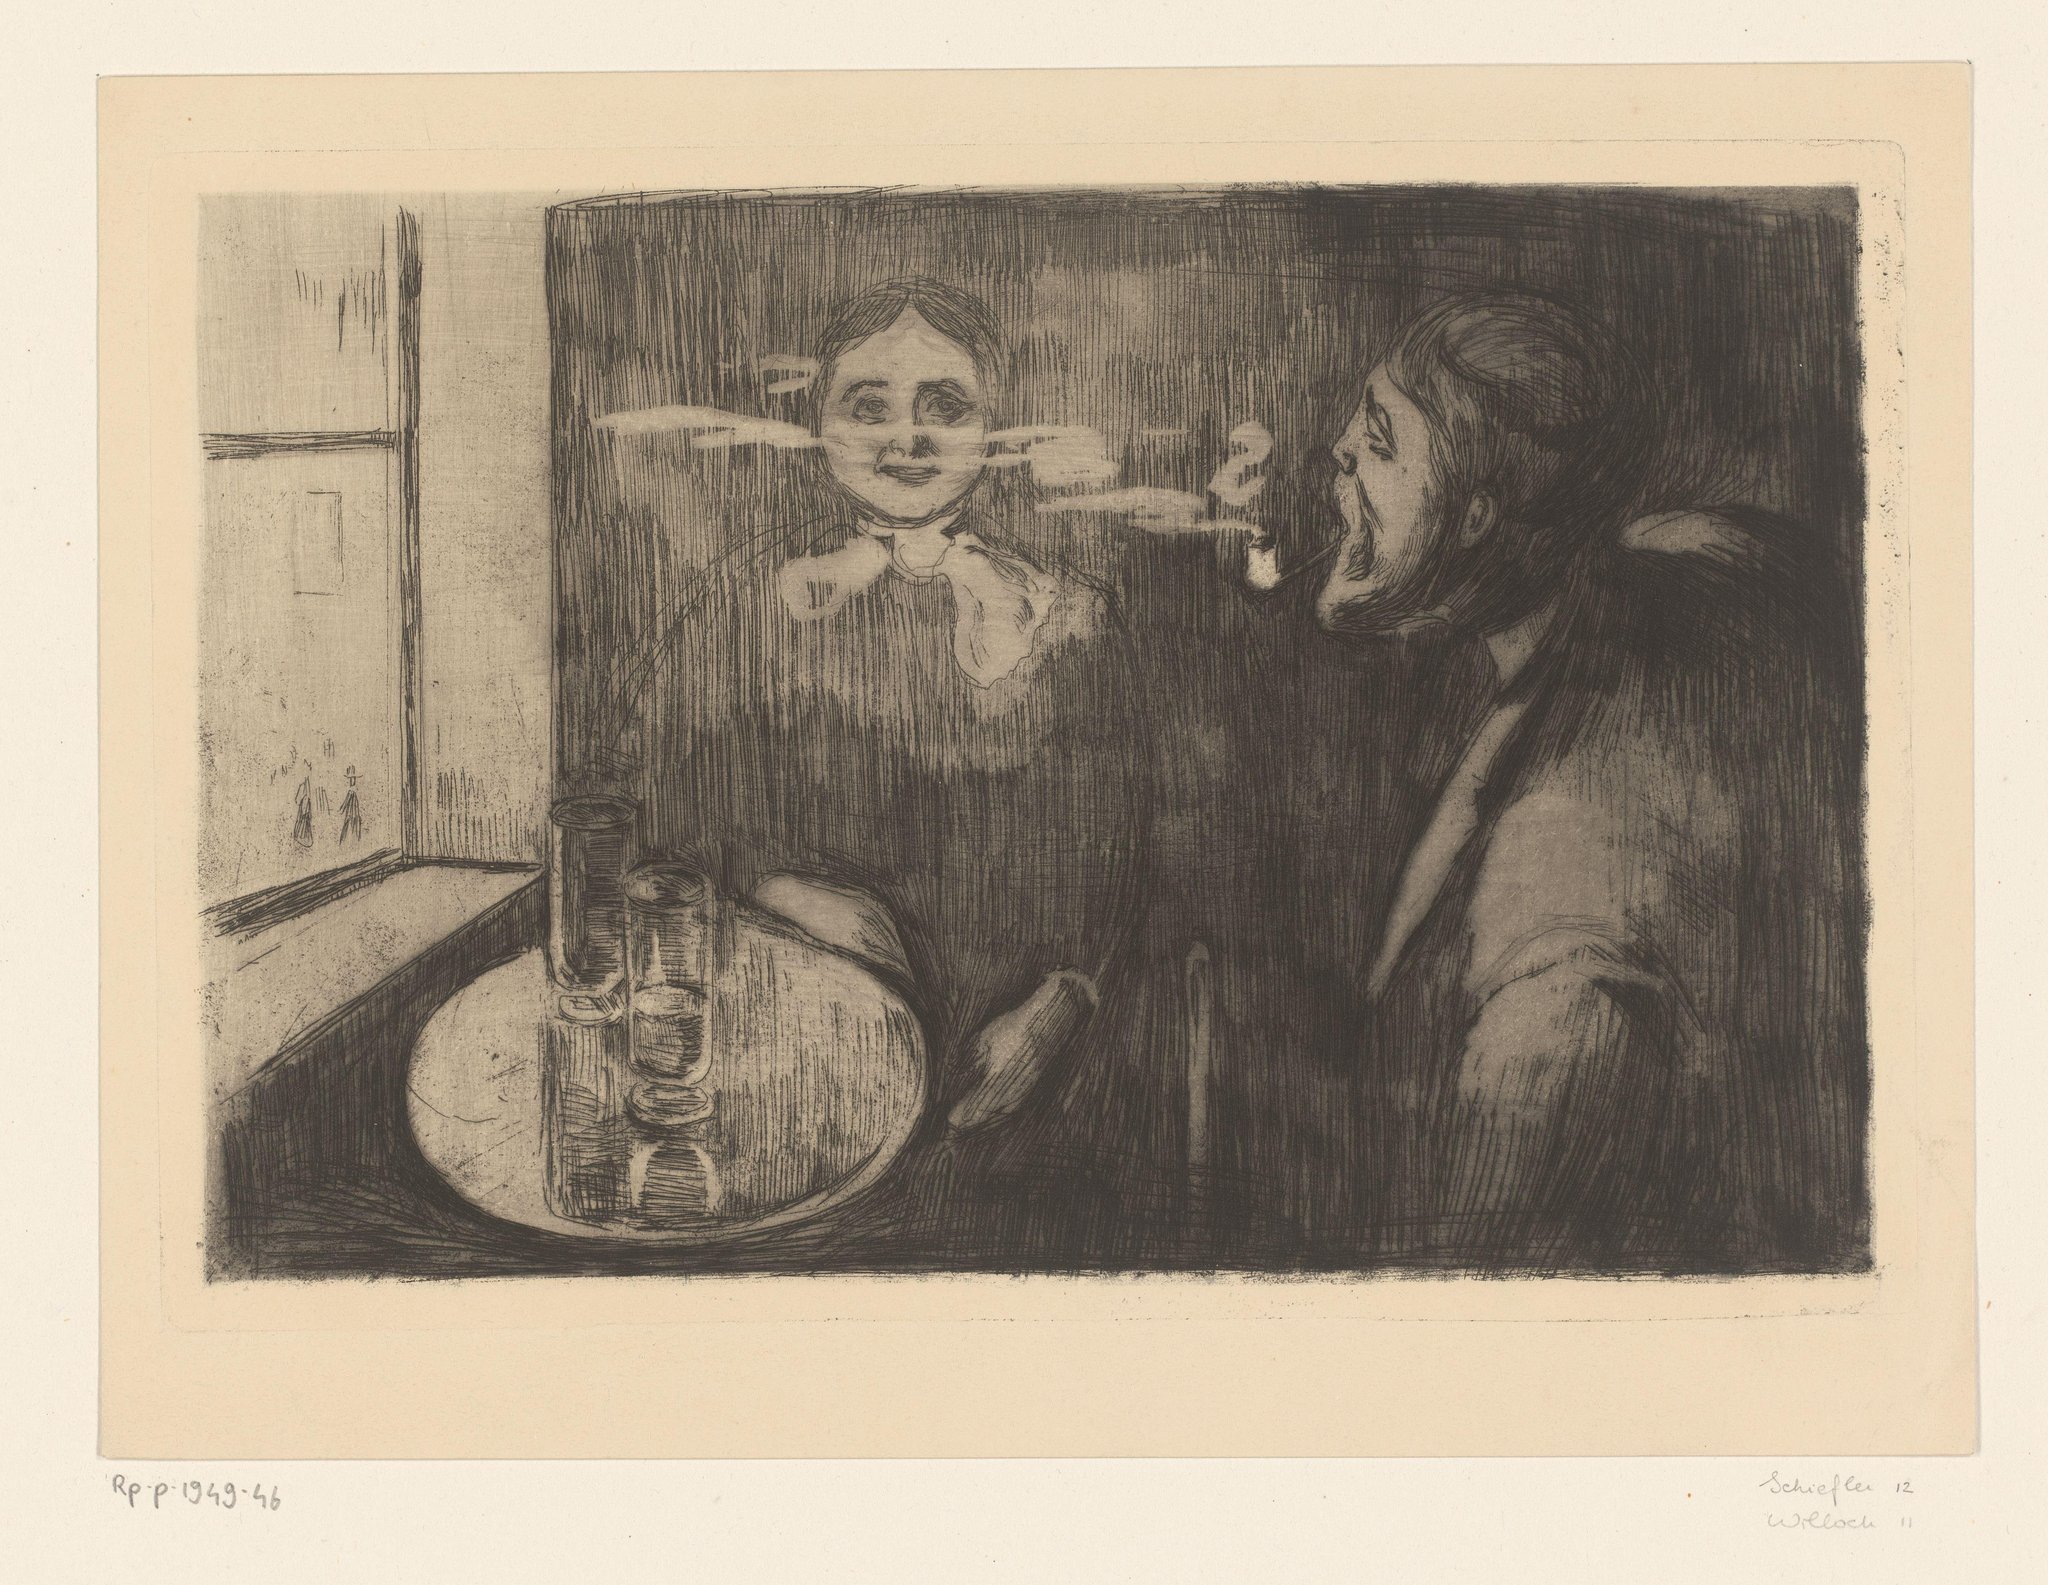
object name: print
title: Tête-à-Tête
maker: edvard munch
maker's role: print maker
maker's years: 1863-1944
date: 1894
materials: paper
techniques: drypoint, etching, intaglio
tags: painter, adult woman, historical persons, pipe ~ tobacco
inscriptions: collector's mark: Lugt 2228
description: De man in de prent is de Noorse schilder Karl Jensen-Hjell.